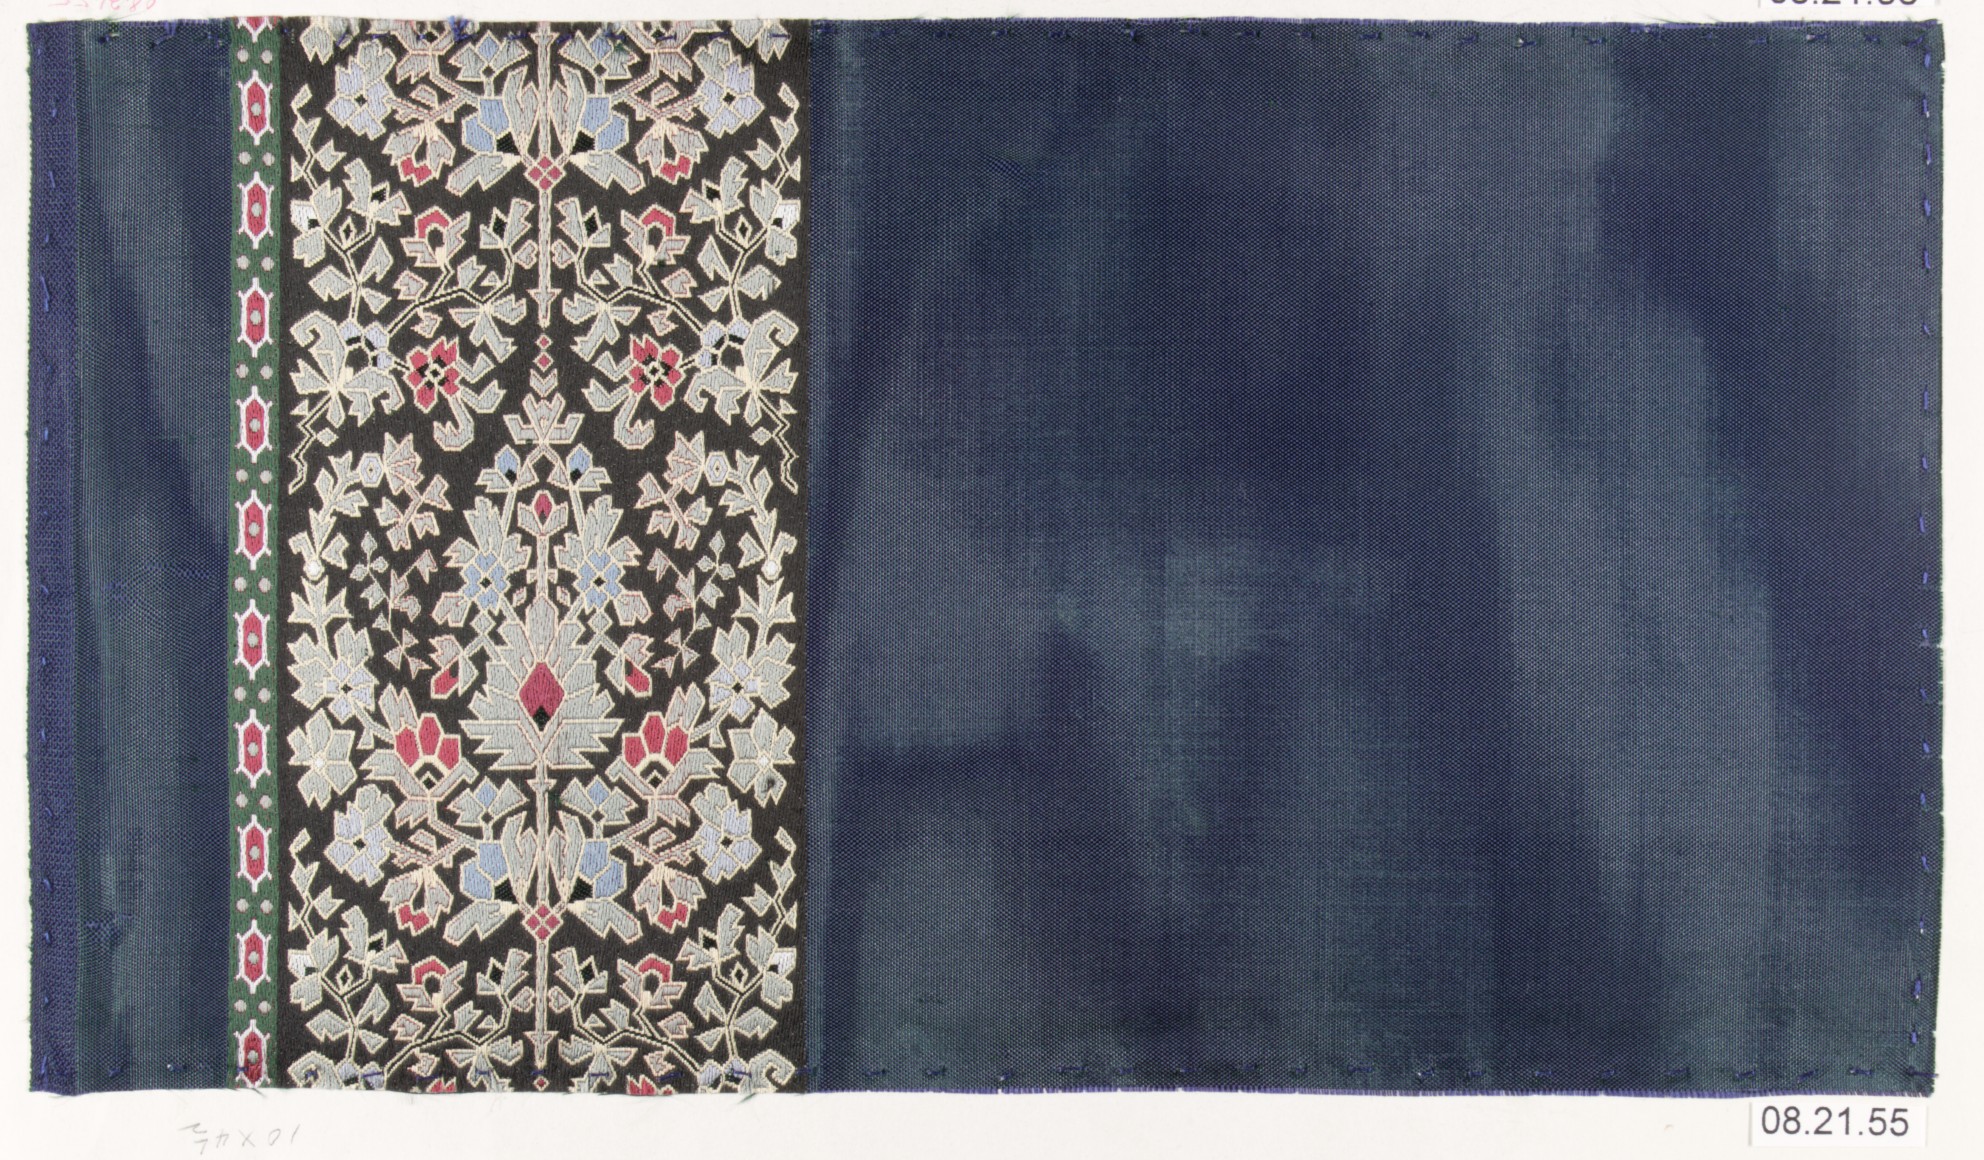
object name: textile sample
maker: Anonymous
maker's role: designer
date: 1900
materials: silk